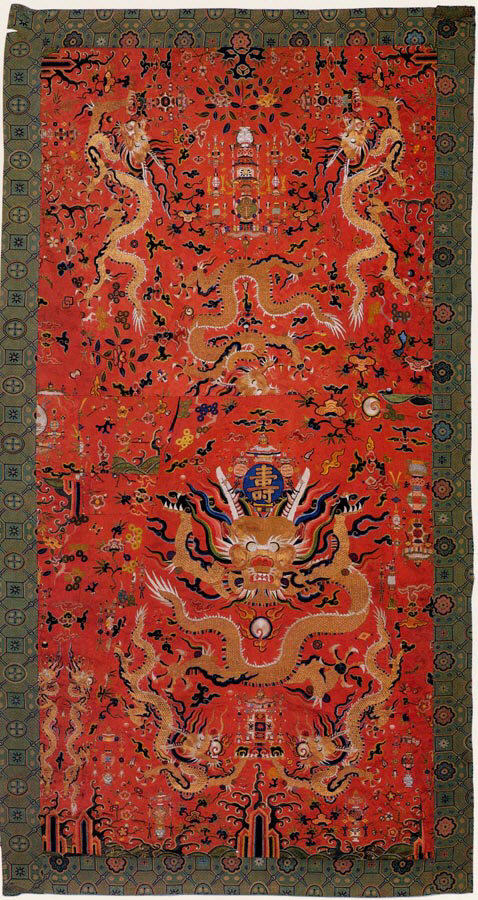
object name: back and sleeve of a dragon robe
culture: chinese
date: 1573-1620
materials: metal thread, silk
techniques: damask, embroidery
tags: dragons